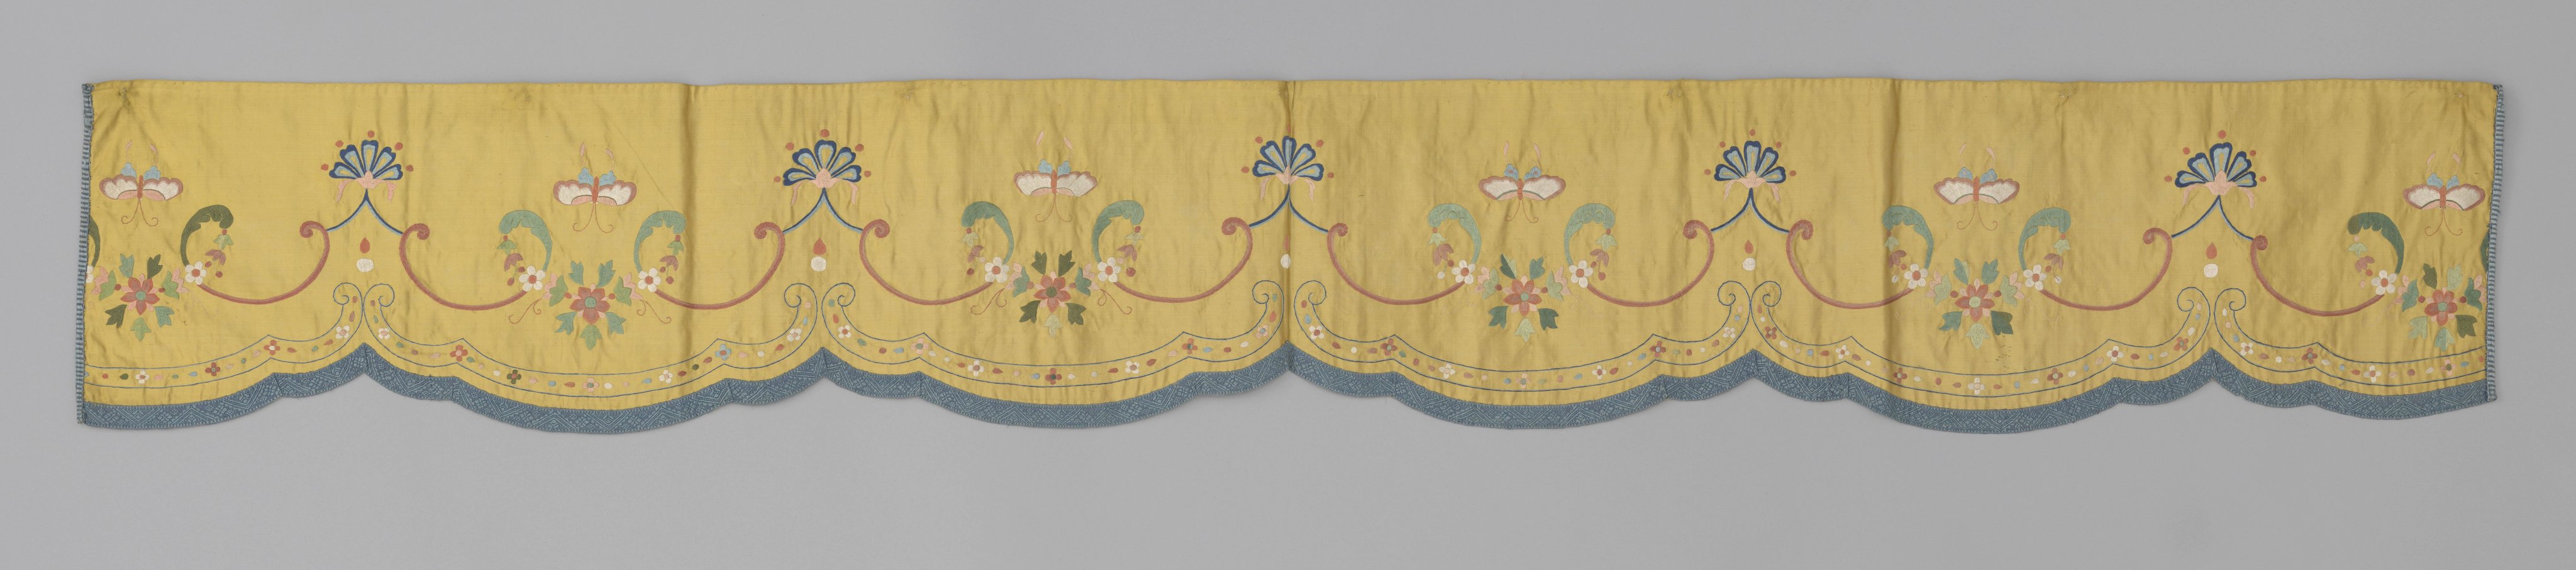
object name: bed covering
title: Lambrekijn, deel van een bedgarnituur, van gele zijde, geborduurd met bloemen en vlinders in veelkleurige zijde en omboord met blauw passement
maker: Anonymous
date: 1720-1740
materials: linen, silk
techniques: embroidered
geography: guangdong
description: Lambrekijn, deel van een bedgarnituur van gele zijde, geborduurd met bloemen en vlinders in veelkleurige zijde, omboord met blauw passement en gevoerd met grof linnen en gele zijde. Bestemd voor de rechterkant van het bed, binnenkant.